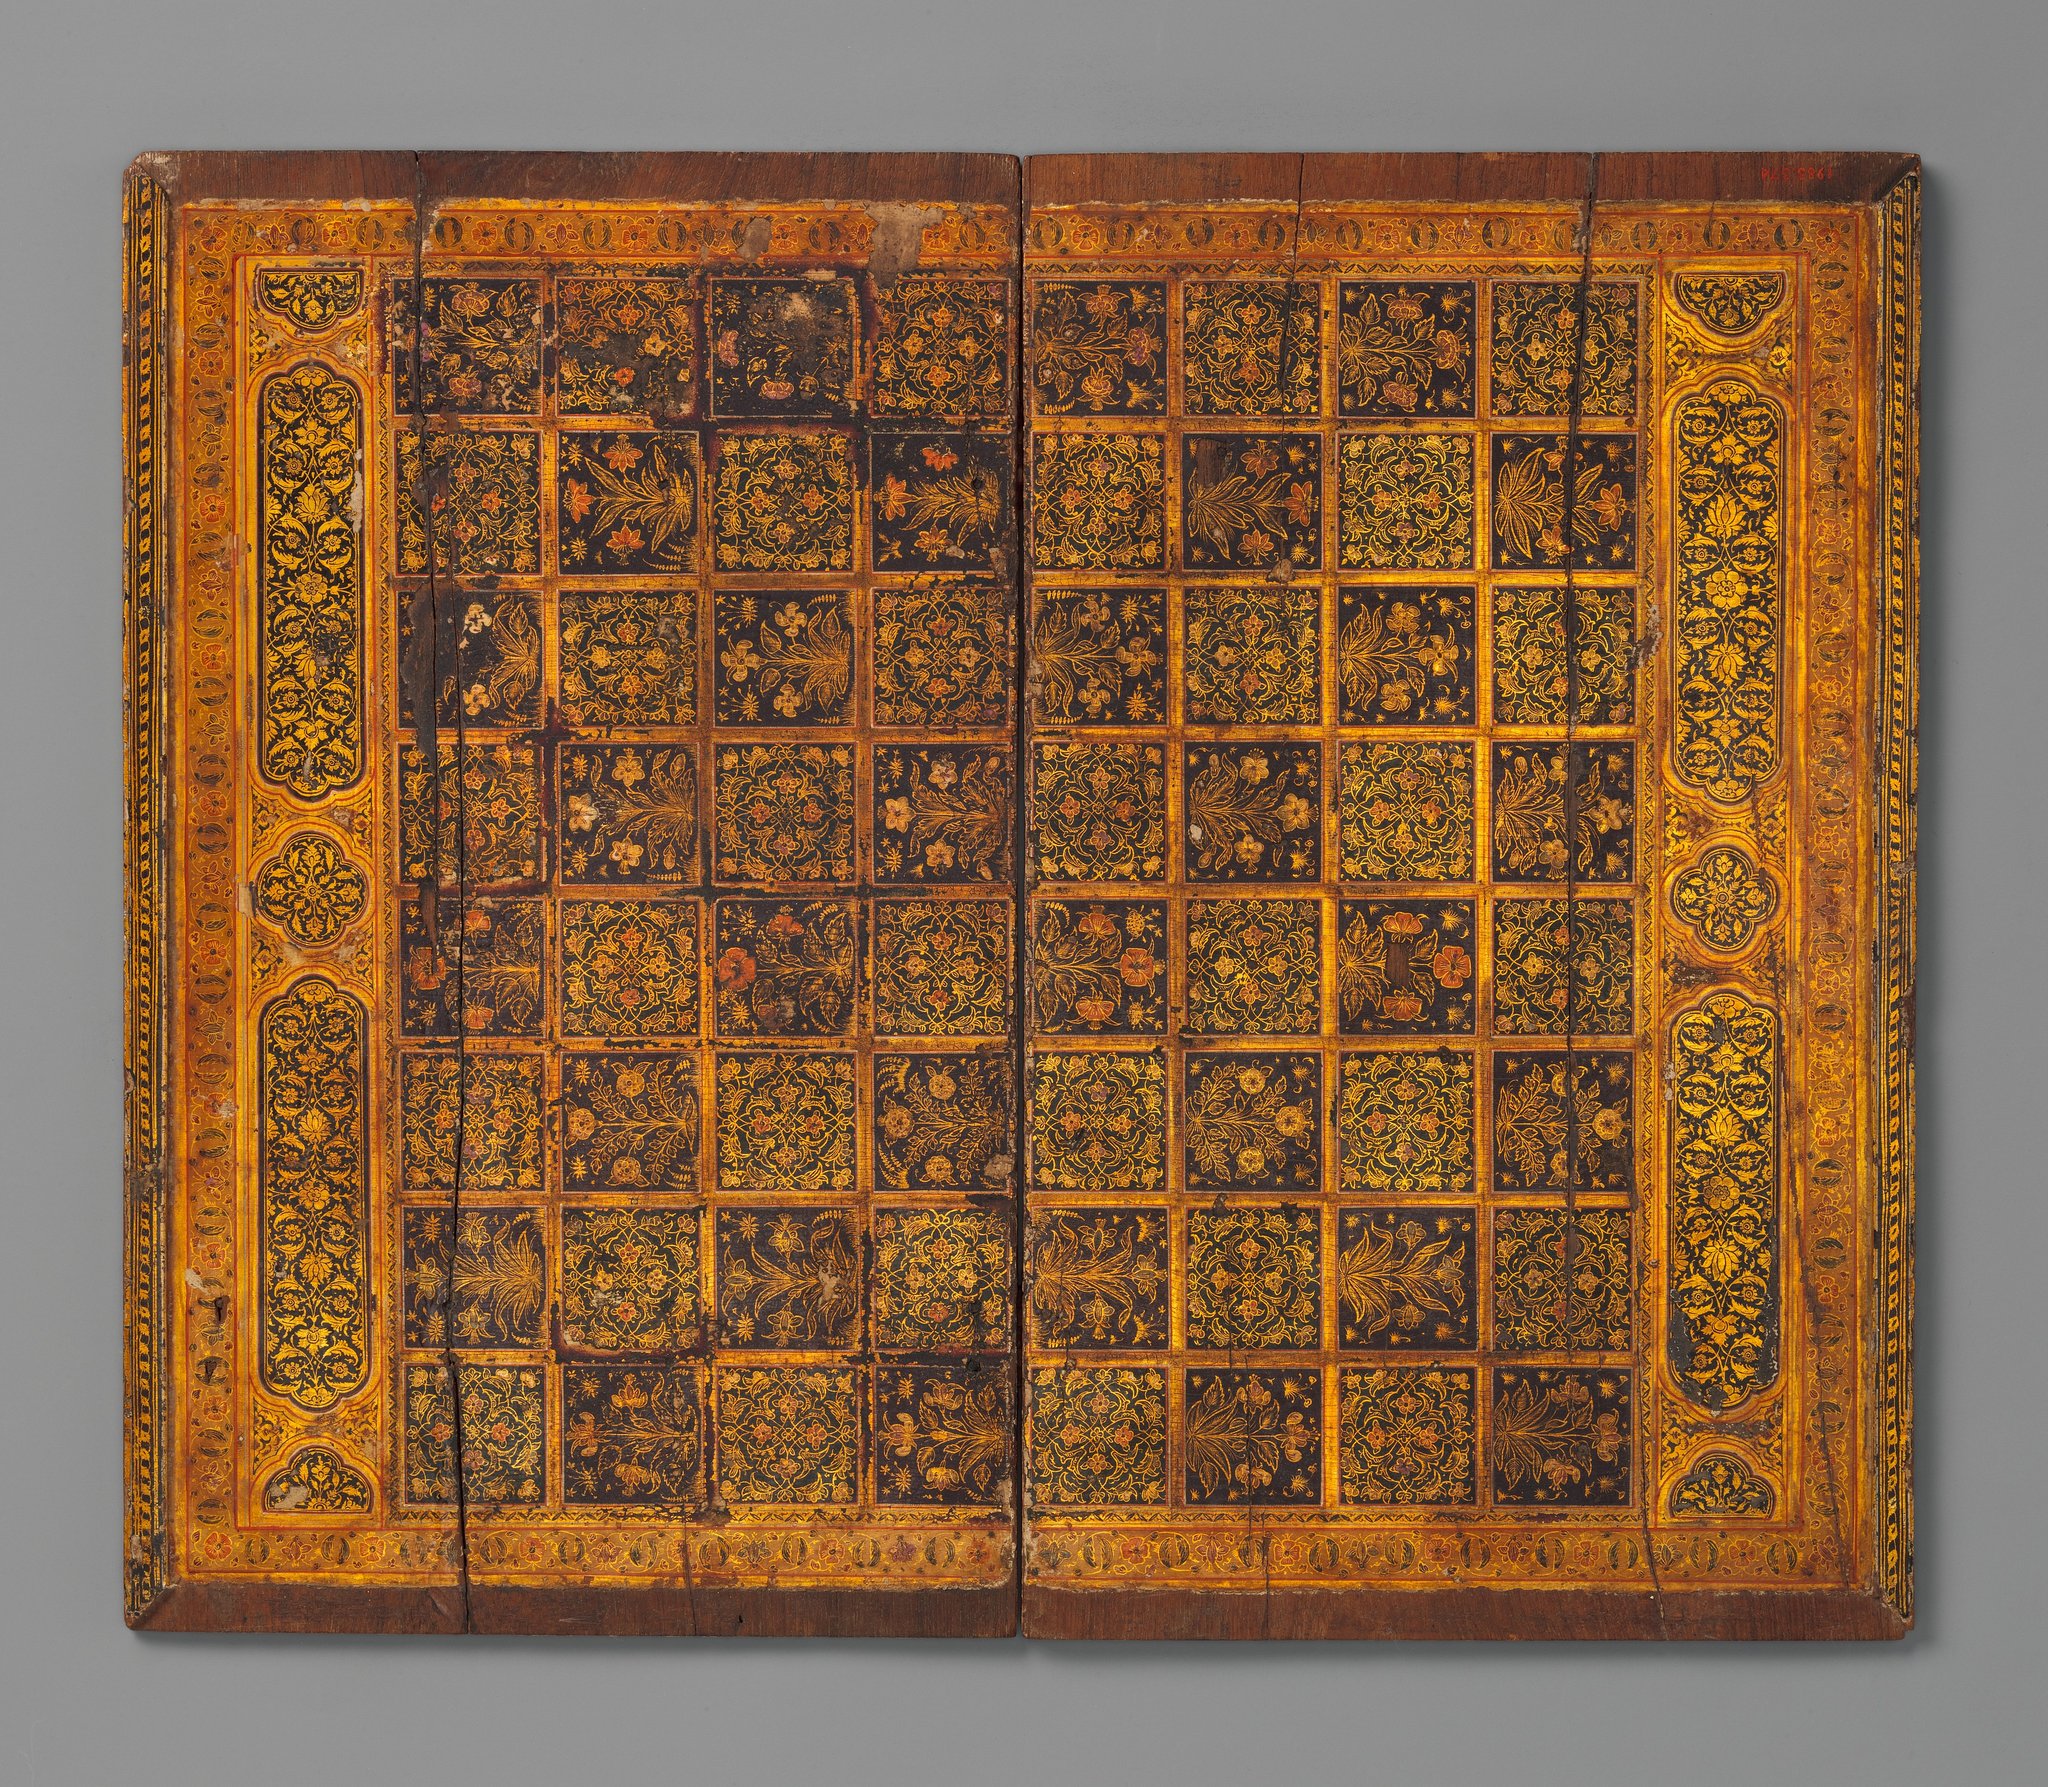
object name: gameboard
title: Painted and Inlaid Game Board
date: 1667-1700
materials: metal, varnish, wood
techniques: gilding, painting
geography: india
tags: games